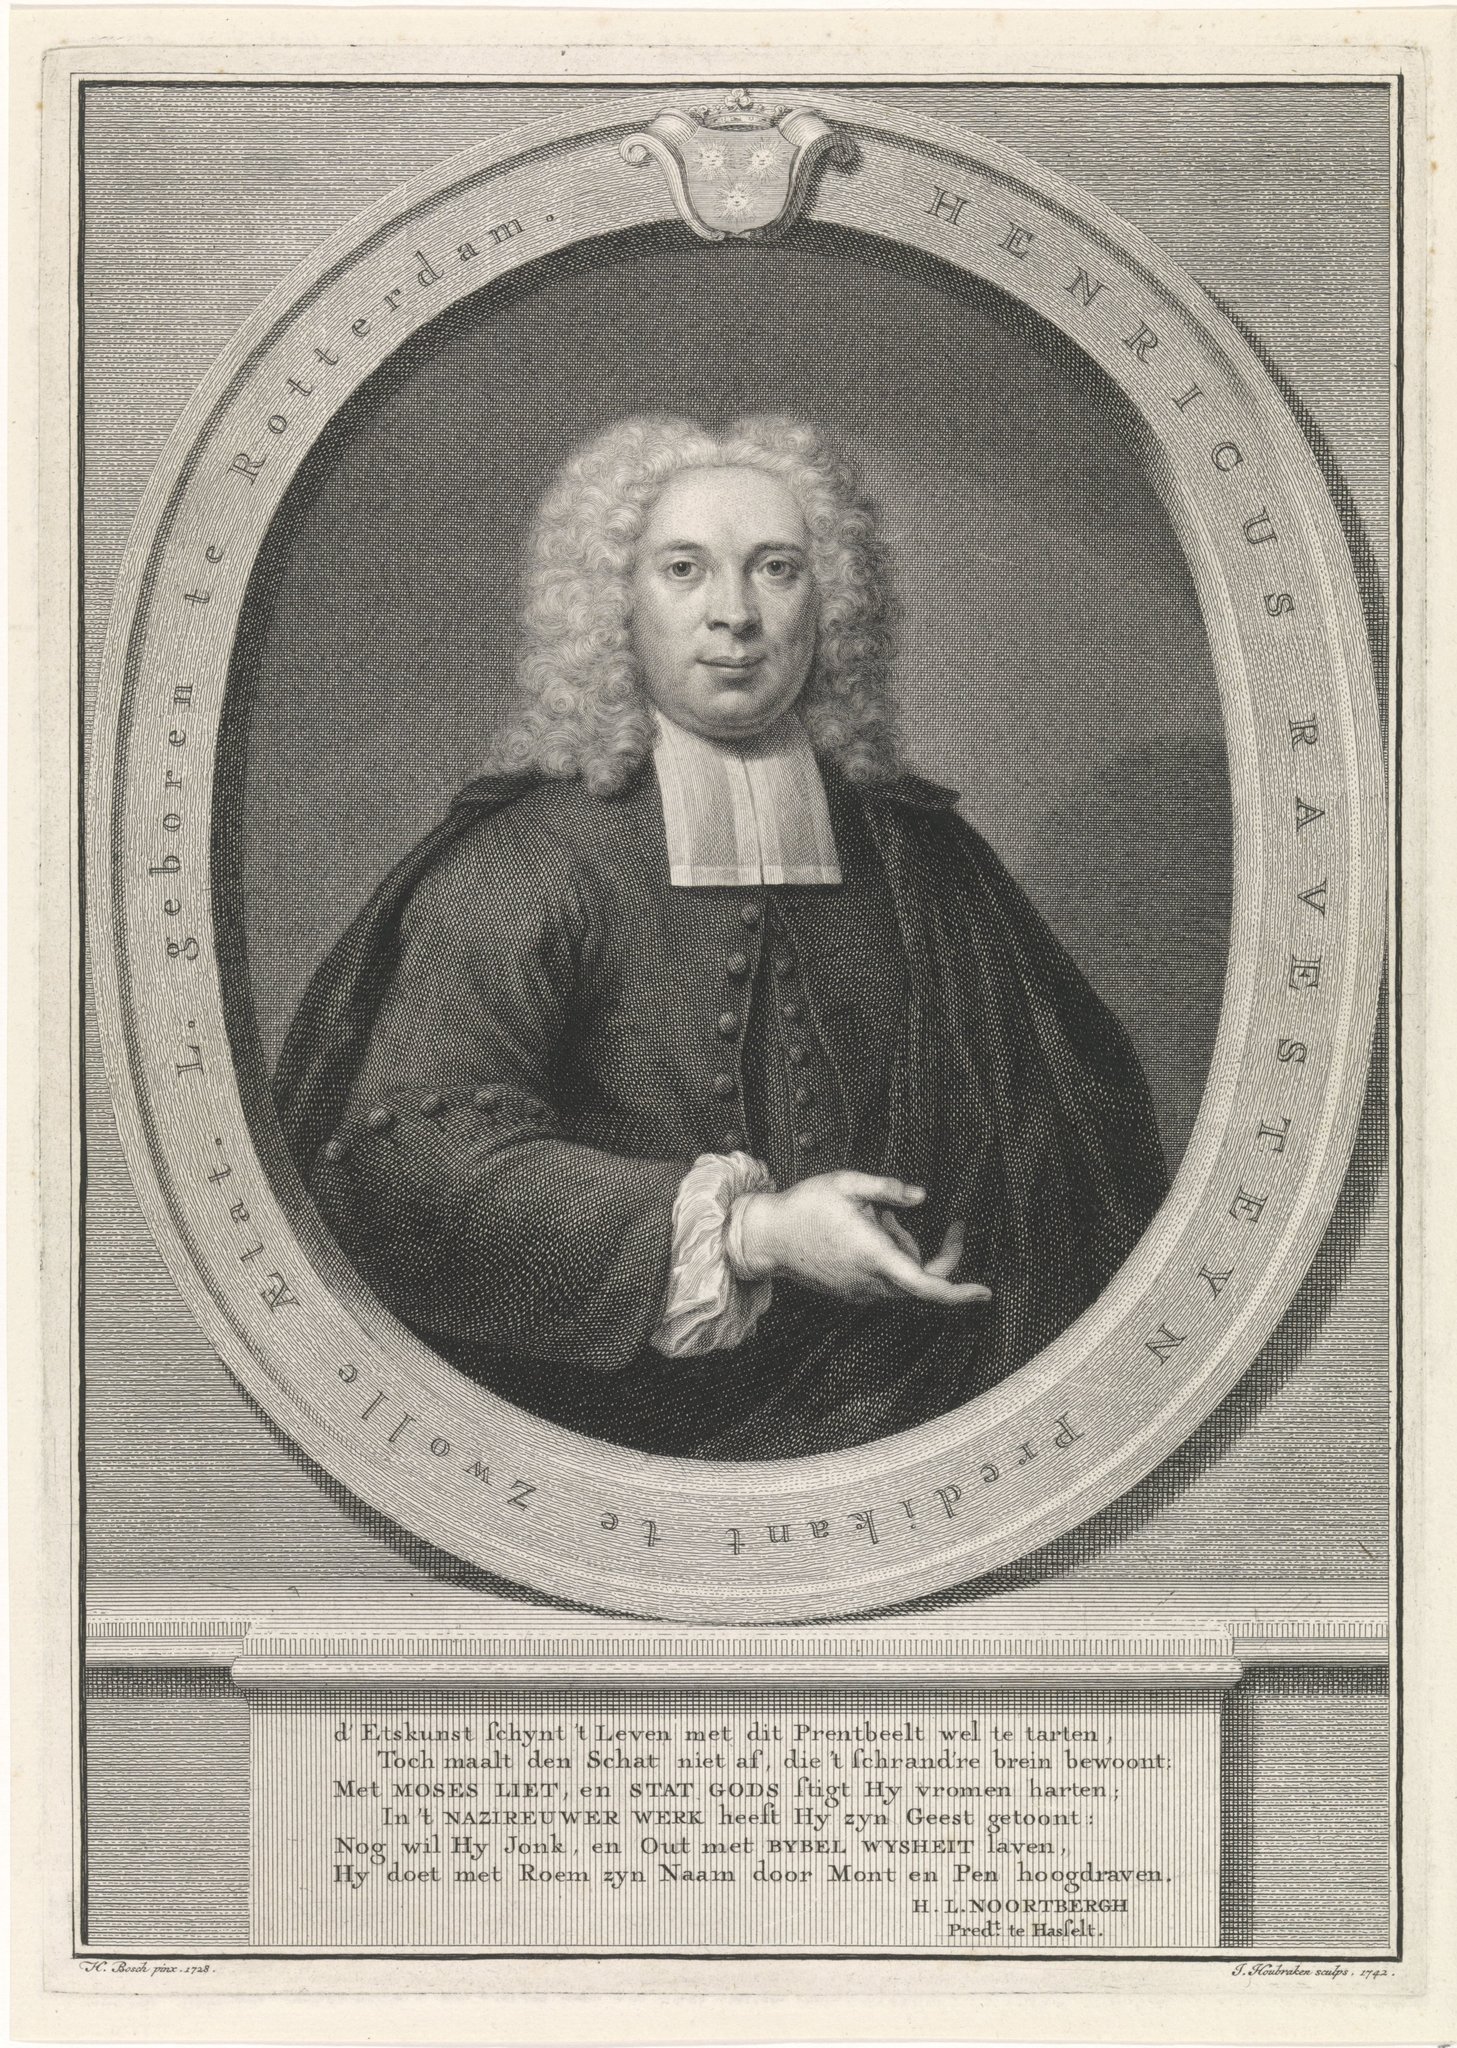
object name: print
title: Portret van Hendrik Ravesteijn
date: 1742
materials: paper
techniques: engraving, etching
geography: amsterdam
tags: rotterdam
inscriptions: collector's mark: Lugt 240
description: Portret ten halven lijve van Hendrik Ravesteijn op 50-jarige leeftijd in een ovaal met randschrift in het Nederlands. Het portret rust op een richel waarop een zesregelig vers in het Nederlands.